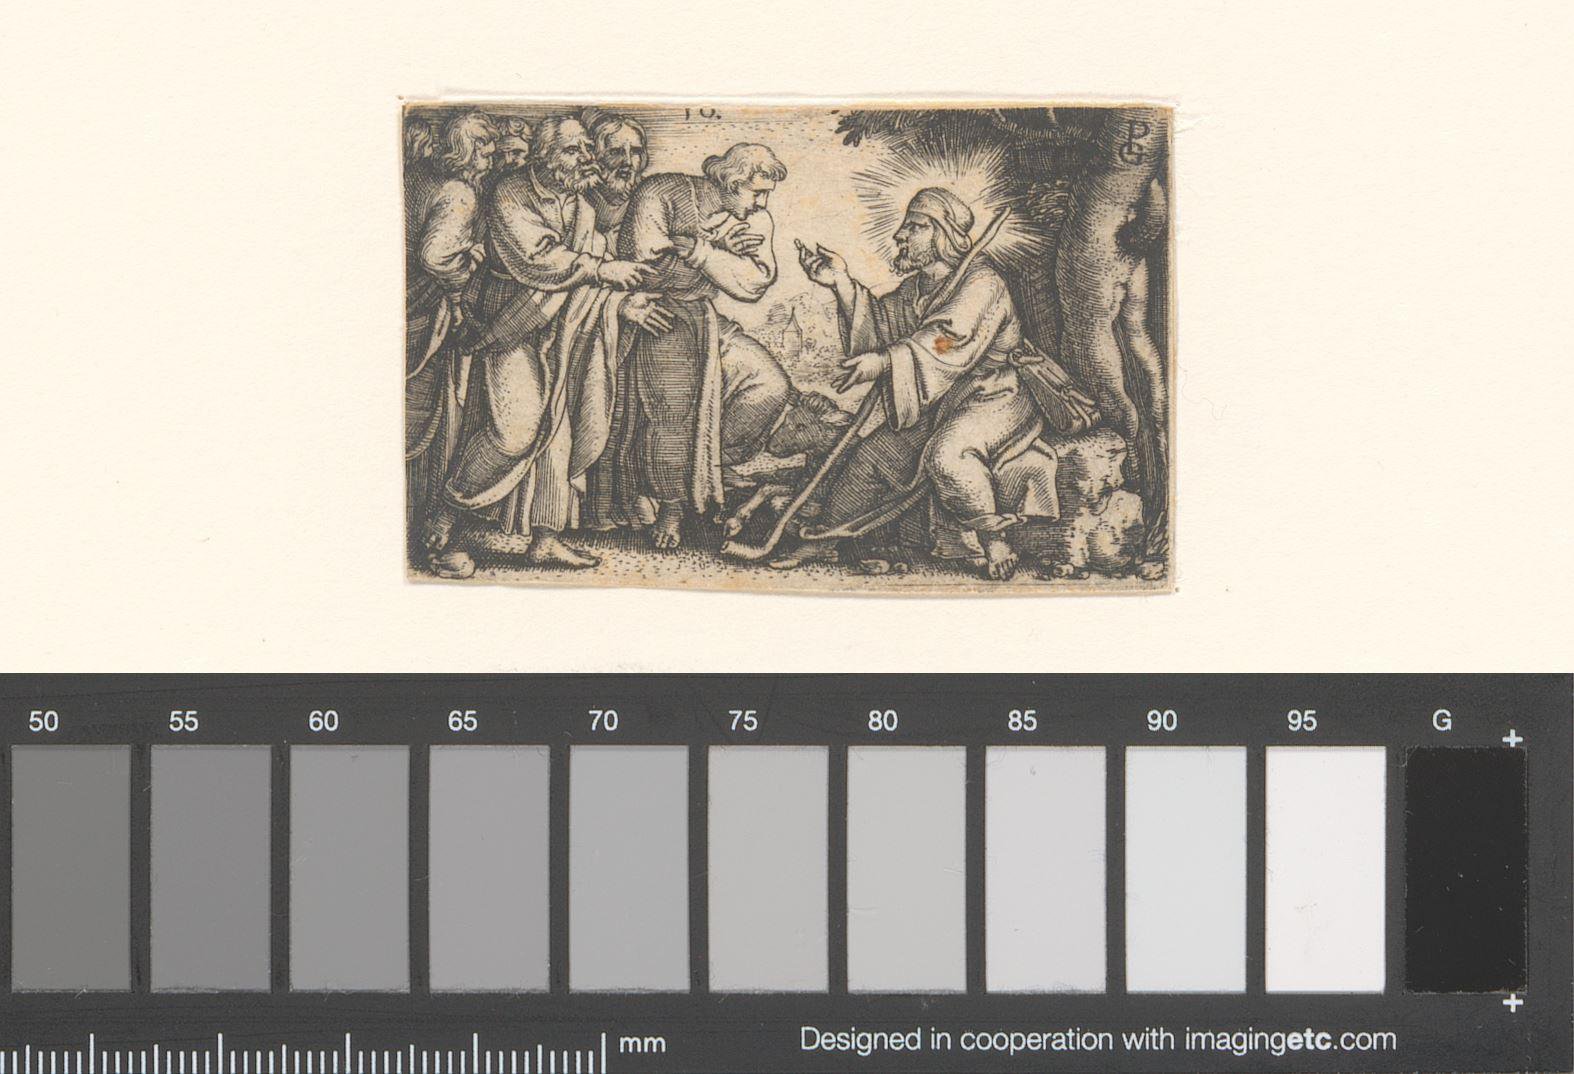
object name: print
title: Christus ontmoet discipelen op weg naar Emmaüs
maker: georg pencz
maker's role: draughtsman, painter, print maker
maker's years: 1500-1550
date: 1534-1535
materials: paper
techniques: engraving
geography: germany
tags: the journey to emmaus: two disciples (cleopas and peter) under way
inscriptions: collector's mark: Lugt 2228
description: Deze prent draagt het nummer 10 dat ook bij latere afdrukken ongewijzigd is gebleven. In de reeks van 26 prenten over het leven van Christus zou het nummer 20 moeten zijn.